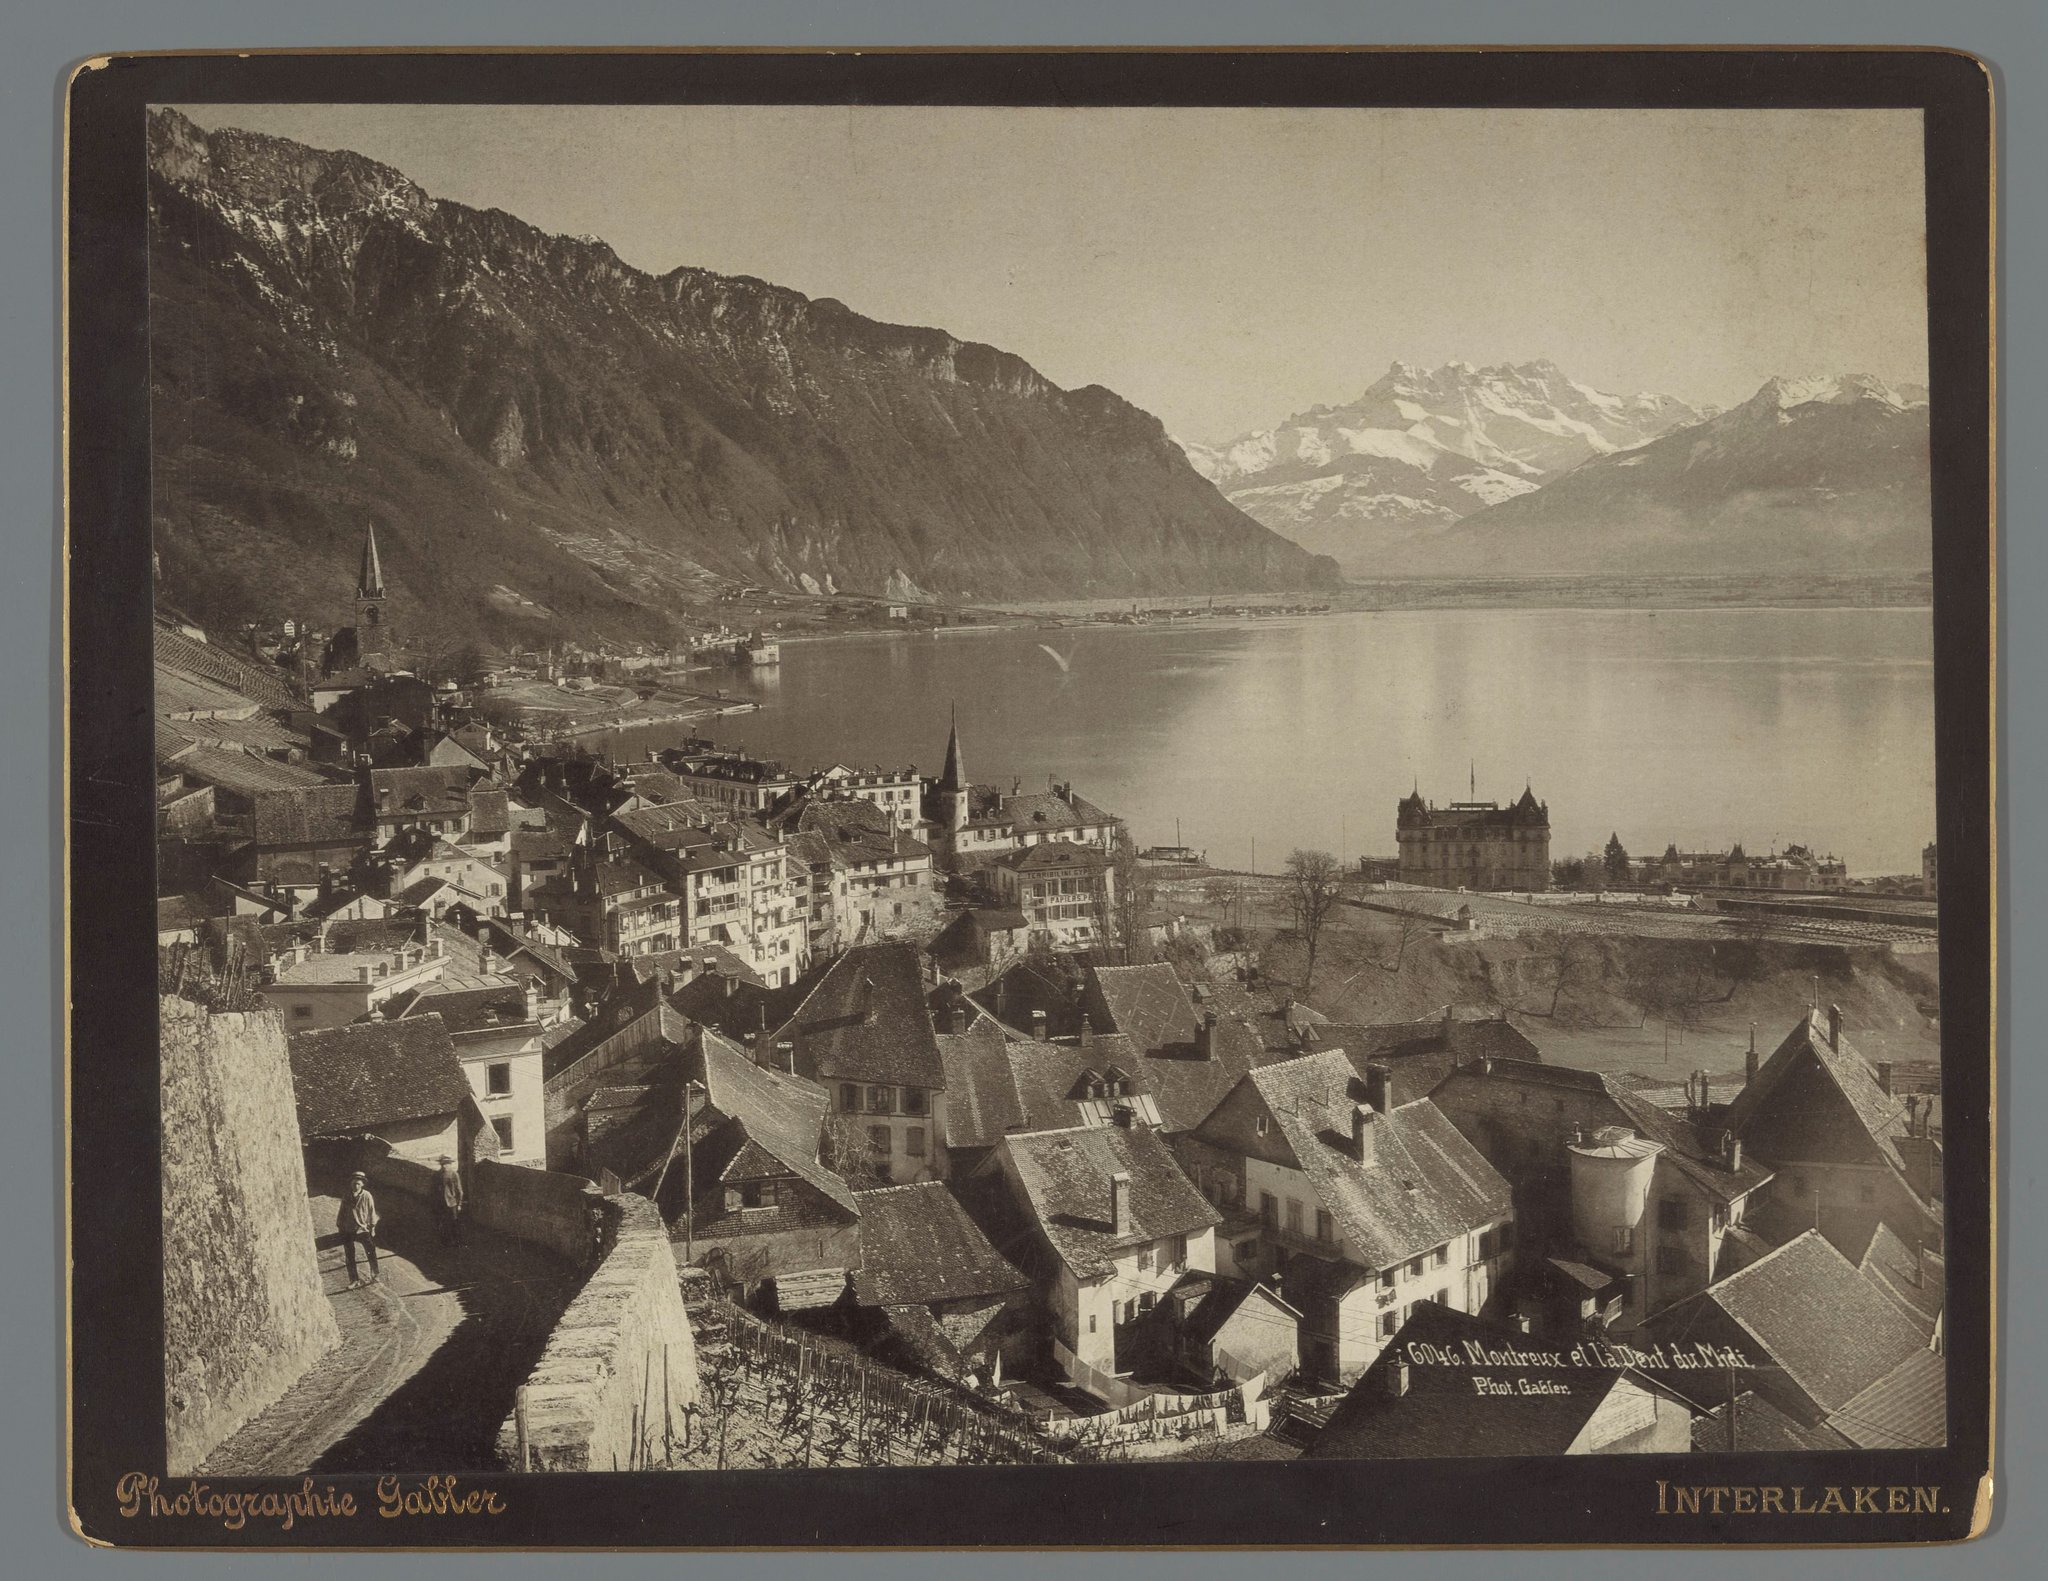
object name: photomechanical print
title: Montreux et la Dent du Midi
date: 1870-1889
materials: cardboard, paper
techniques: photograph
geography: interlaken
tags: city-view in general; 'veduta', mountains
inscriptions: name: ‘Lith. E. d. Hofmann. Thun (Schweiz)’